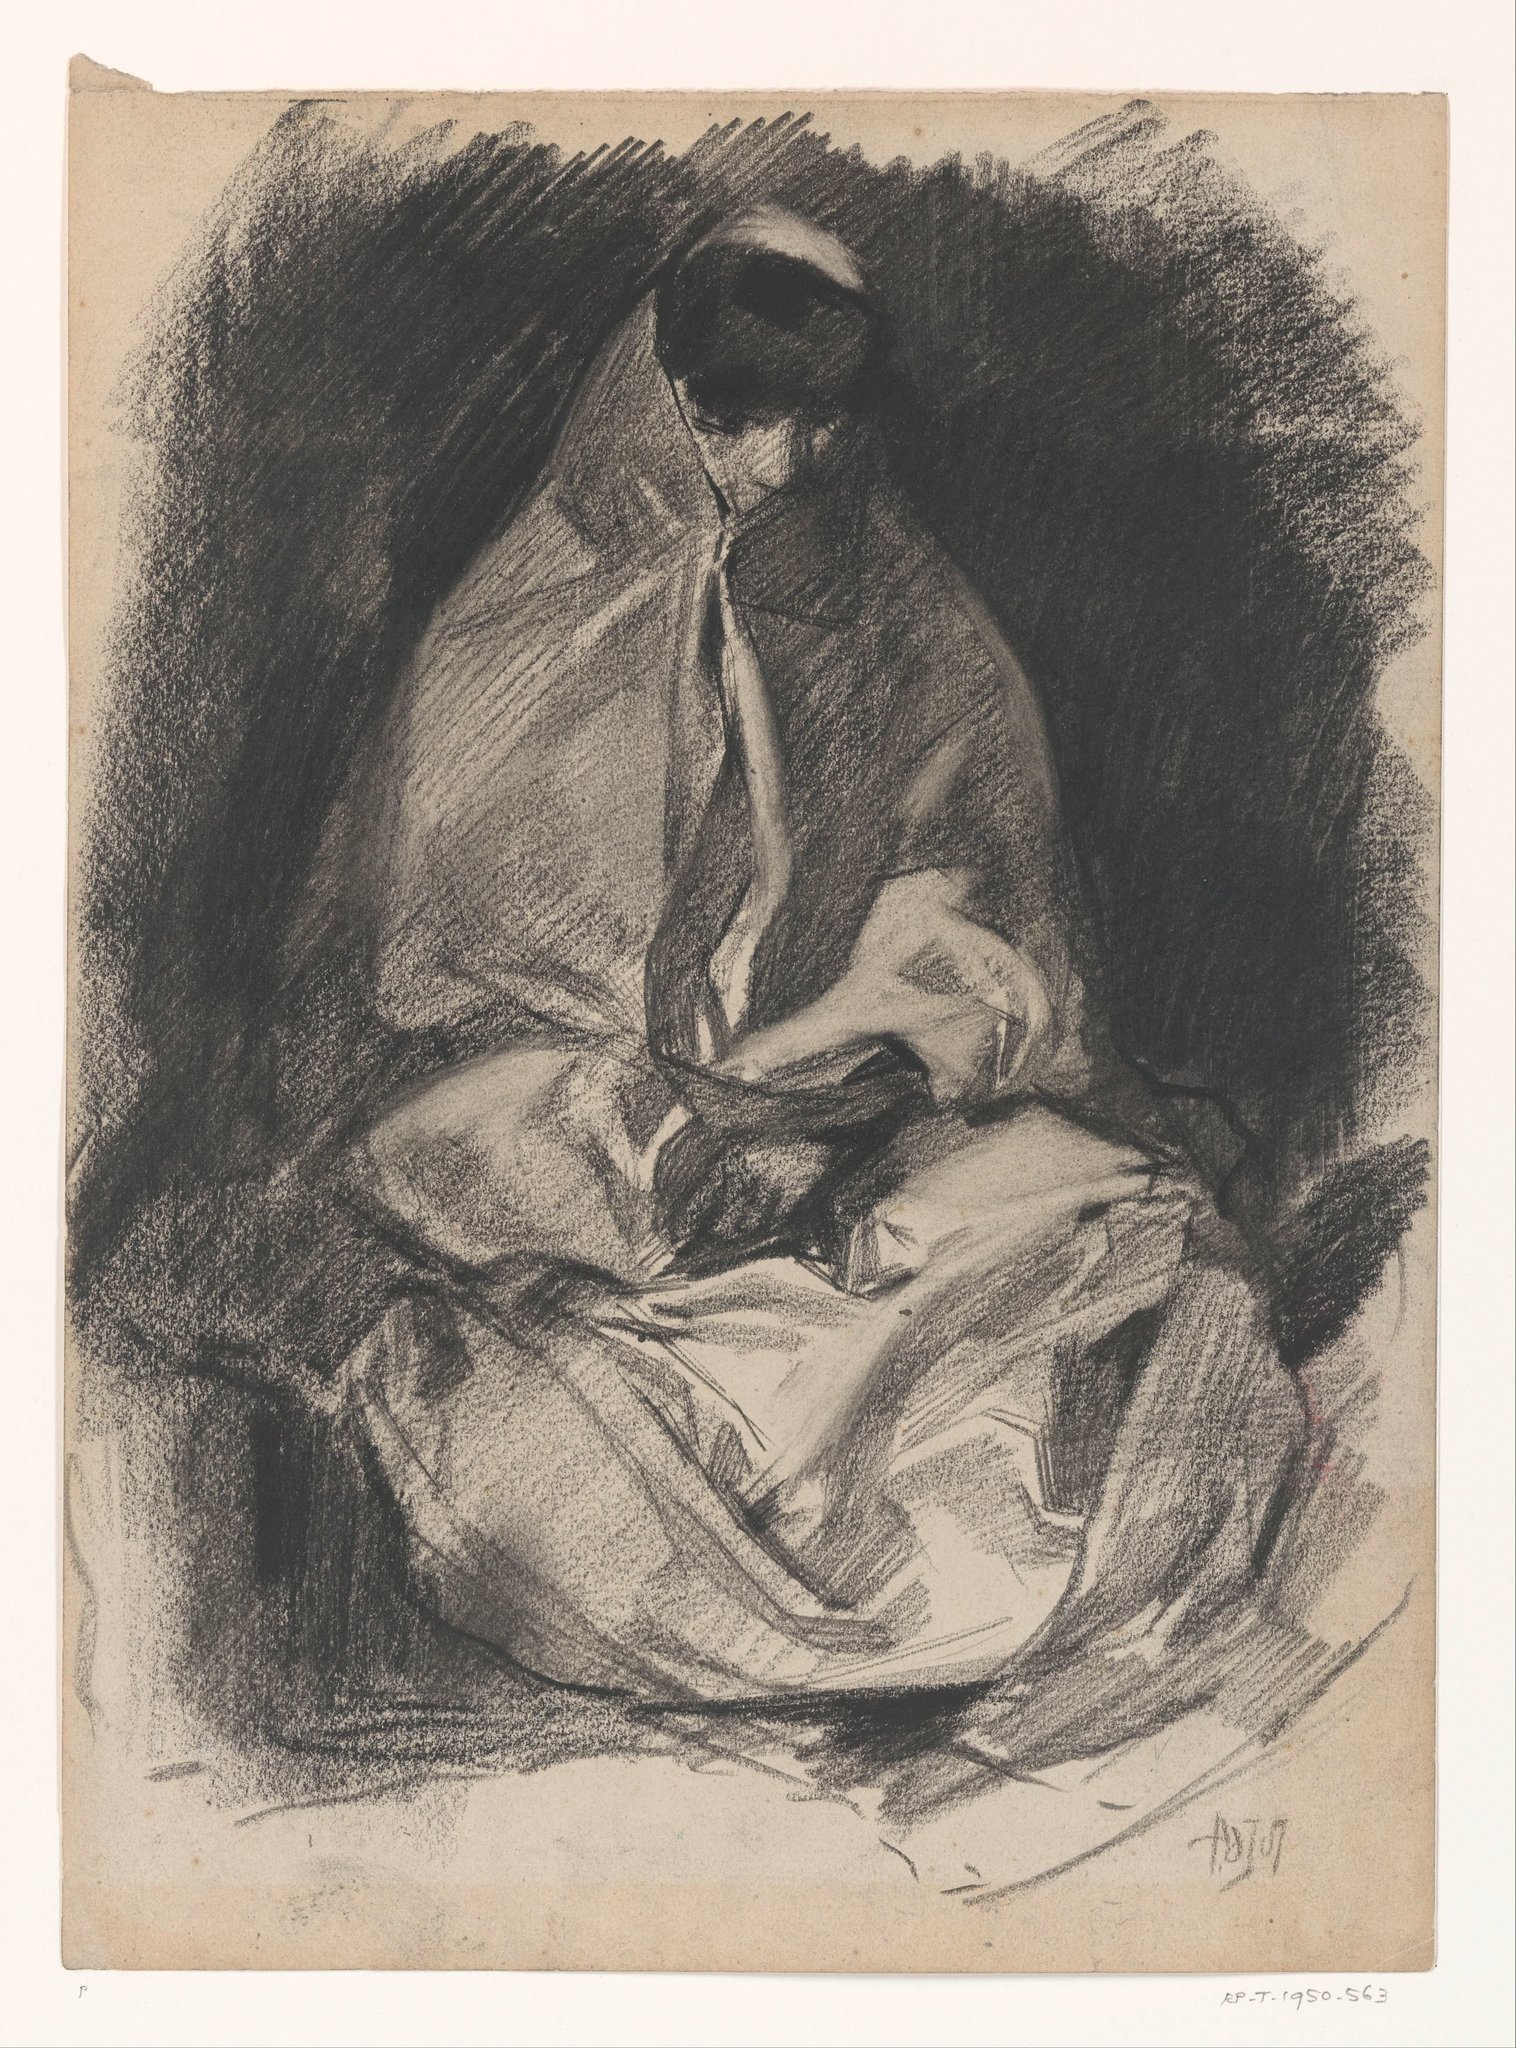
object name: drawing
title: Zittende Marokkaanse vrouw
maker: pieter de josselin de jong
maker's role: draughtsman, painter, print maker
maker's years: 1861-1906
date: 1871-1906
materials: chalk, paper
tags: marokko